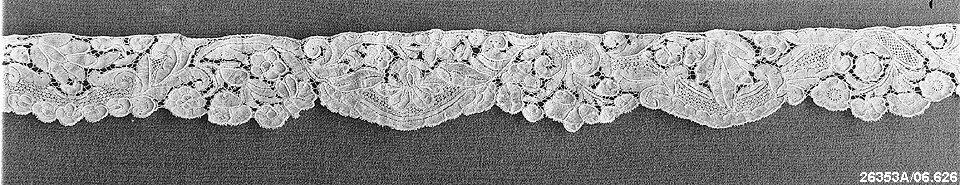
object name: fragment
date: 1801-1900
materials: lace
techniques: lace